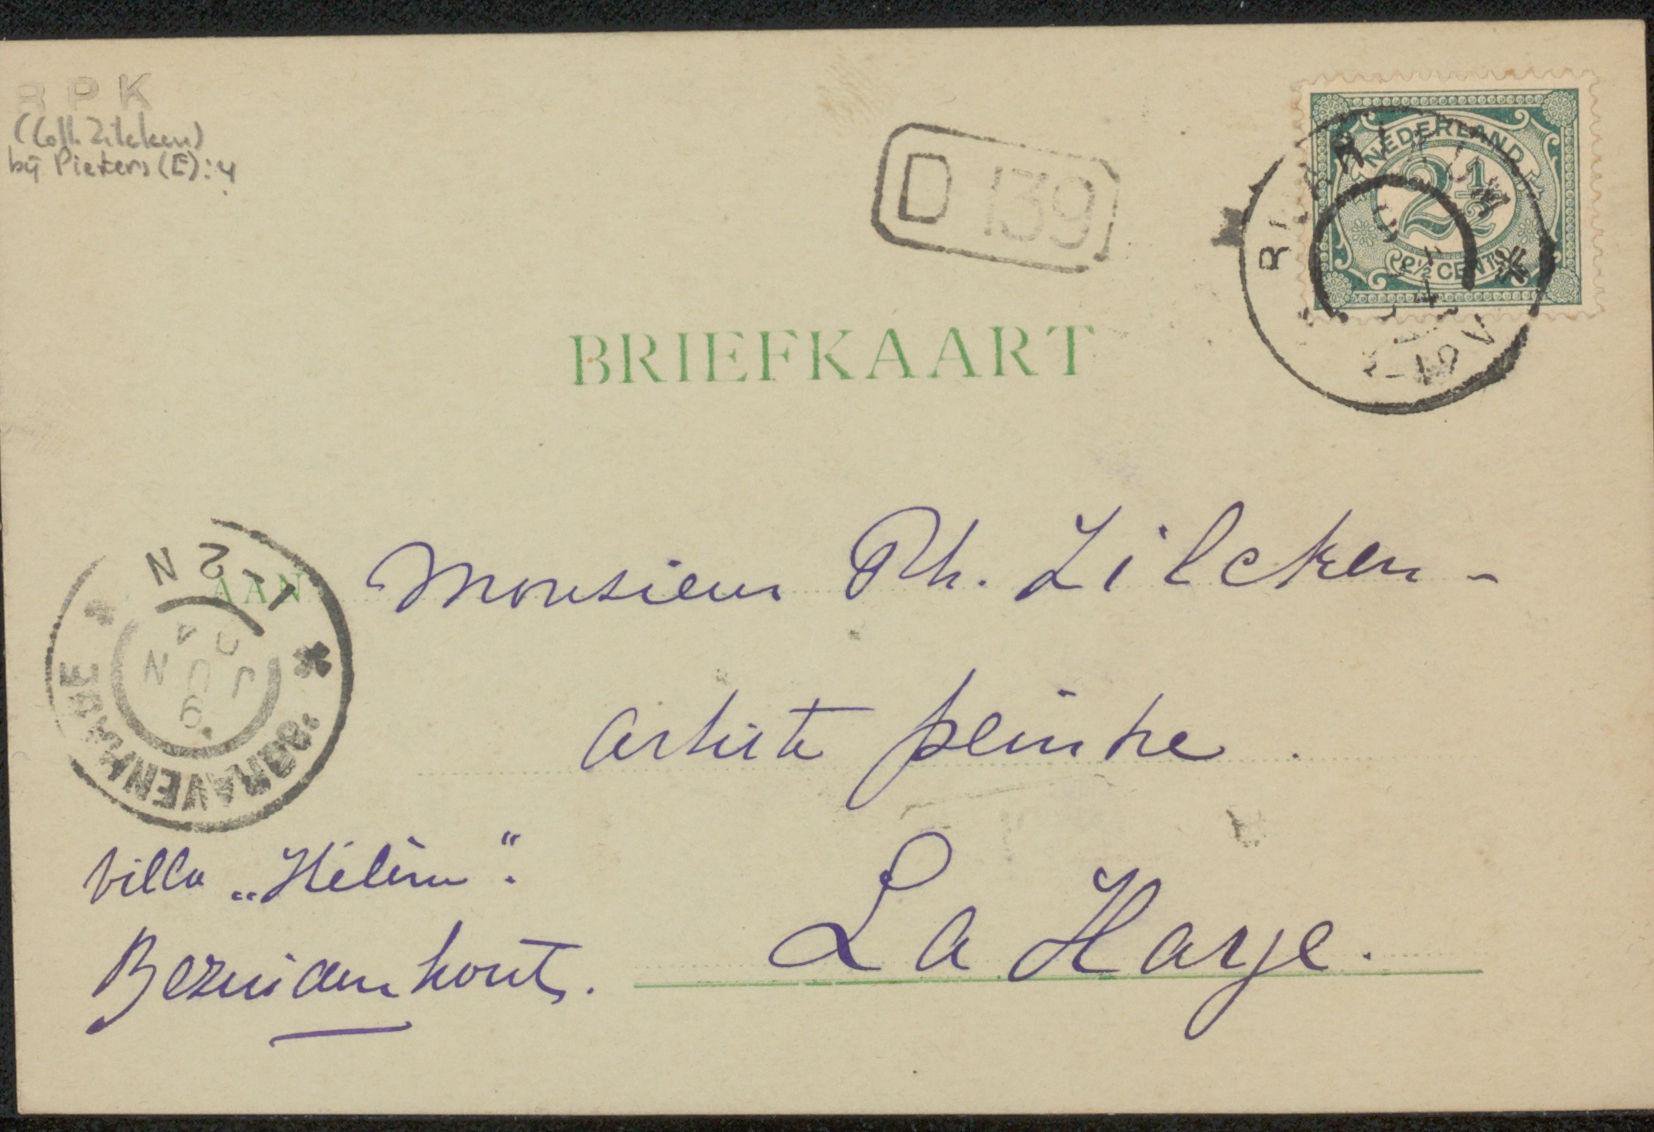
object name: postcard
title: Briefkaart aan Philip Zilcken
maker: evert pieters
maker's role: draughtsman, painter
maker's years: 1856-1932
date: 1904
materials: cardboard, ink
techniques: pen, writing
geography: blaricum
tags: the hague, painter, draughtsman, philip zilcken, drawing, photography, cinematography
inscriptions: collector's mark: ‘RPK’